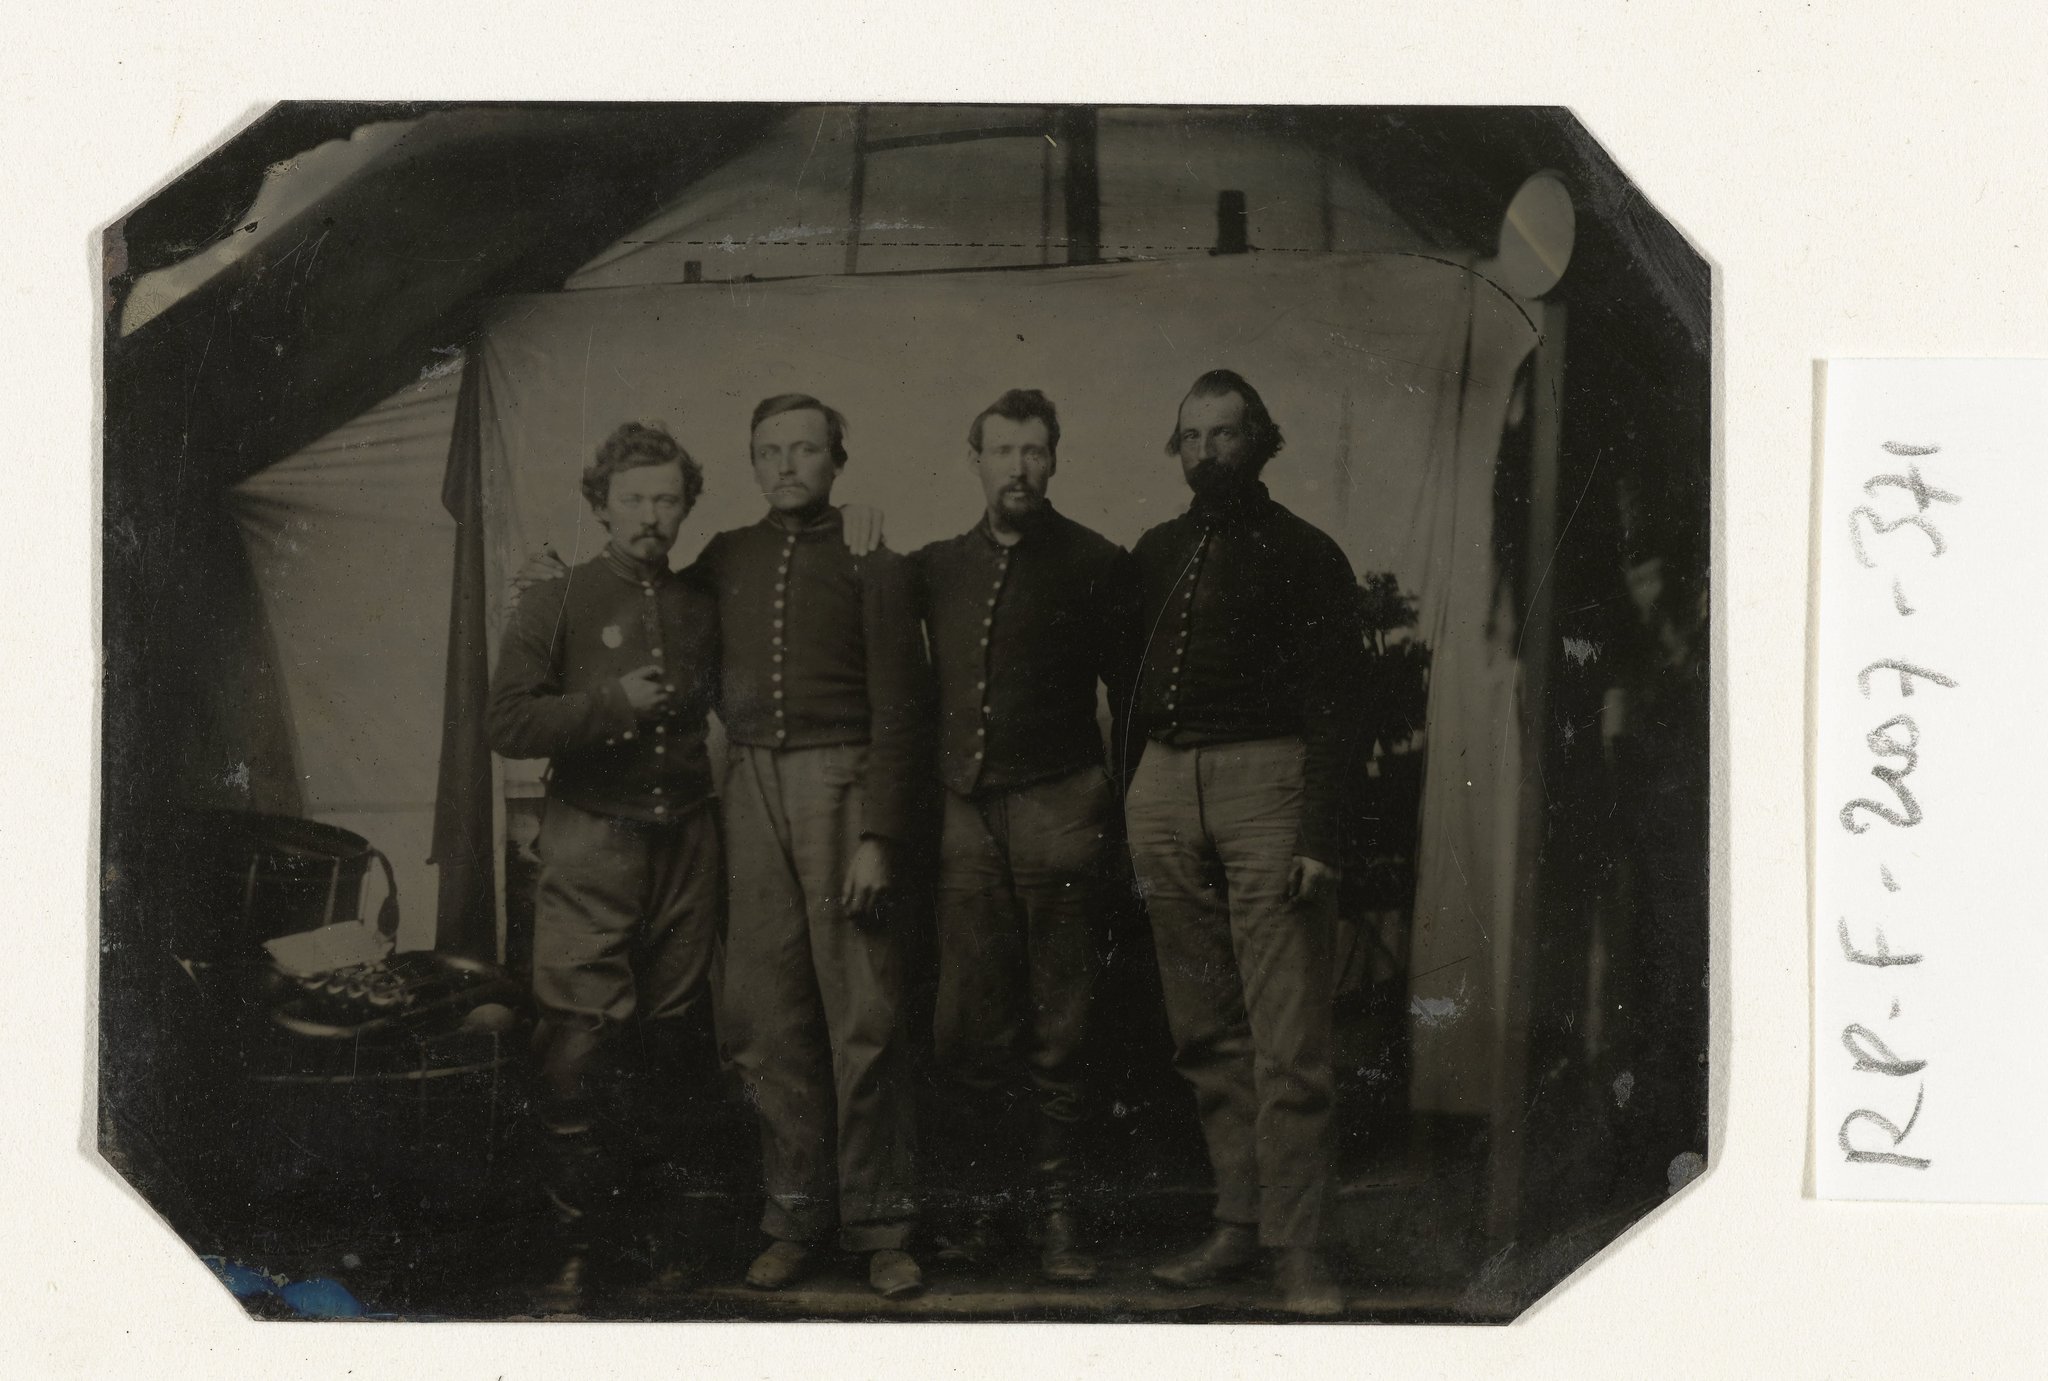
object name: photograph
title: Portret van vier militairen, staand in een tent voor een effen achtergrond, met links op een stoel een blaasinstrument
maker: Anonymous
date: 1860-1870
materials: metal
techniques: ferrotyping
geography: united states